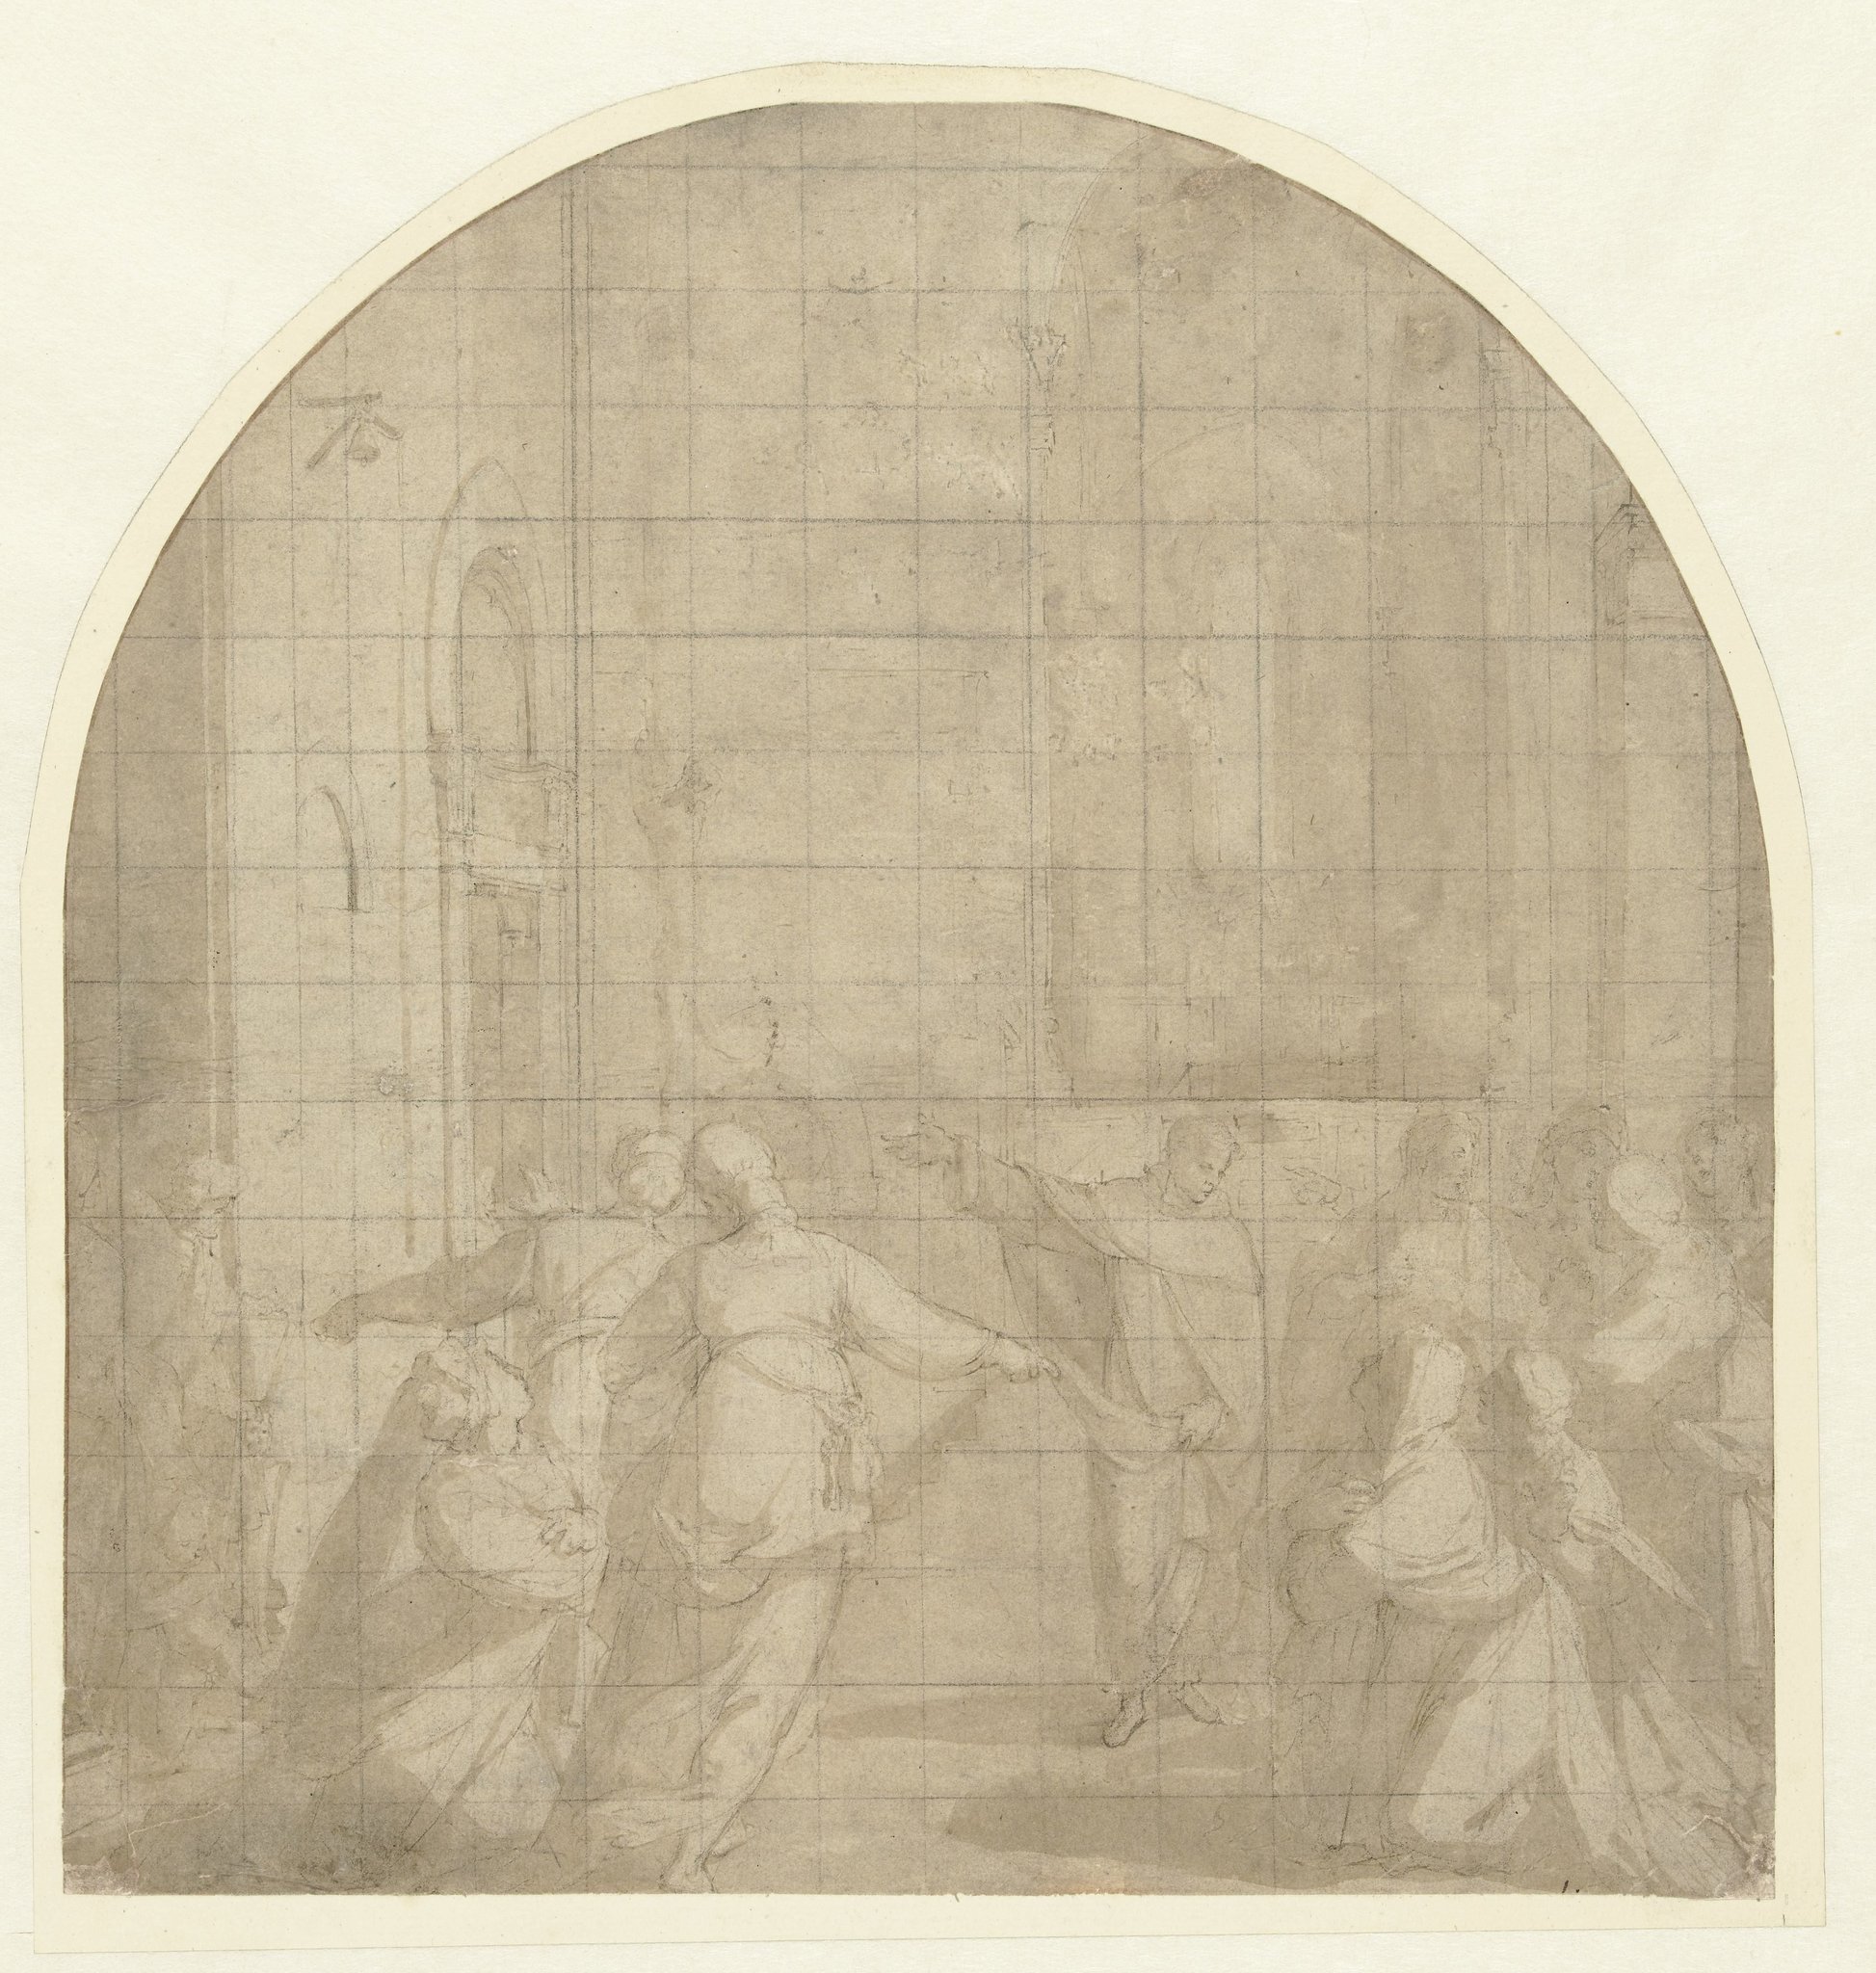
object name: drawing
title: Heilige Dominicus en de ketterse vrouwen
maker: bernardino poccetti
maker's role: draughtsman, painter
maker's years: 1545-1612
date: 1580-1585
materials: chalk, ink, paper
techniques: brush, pen, drawing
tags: dominic(us) guzman of calerueja, founder of the order of preachers (or dominican (black) friars; possible attributes: book, dog with flaming torch, lily, loaf of bread, rosary, star